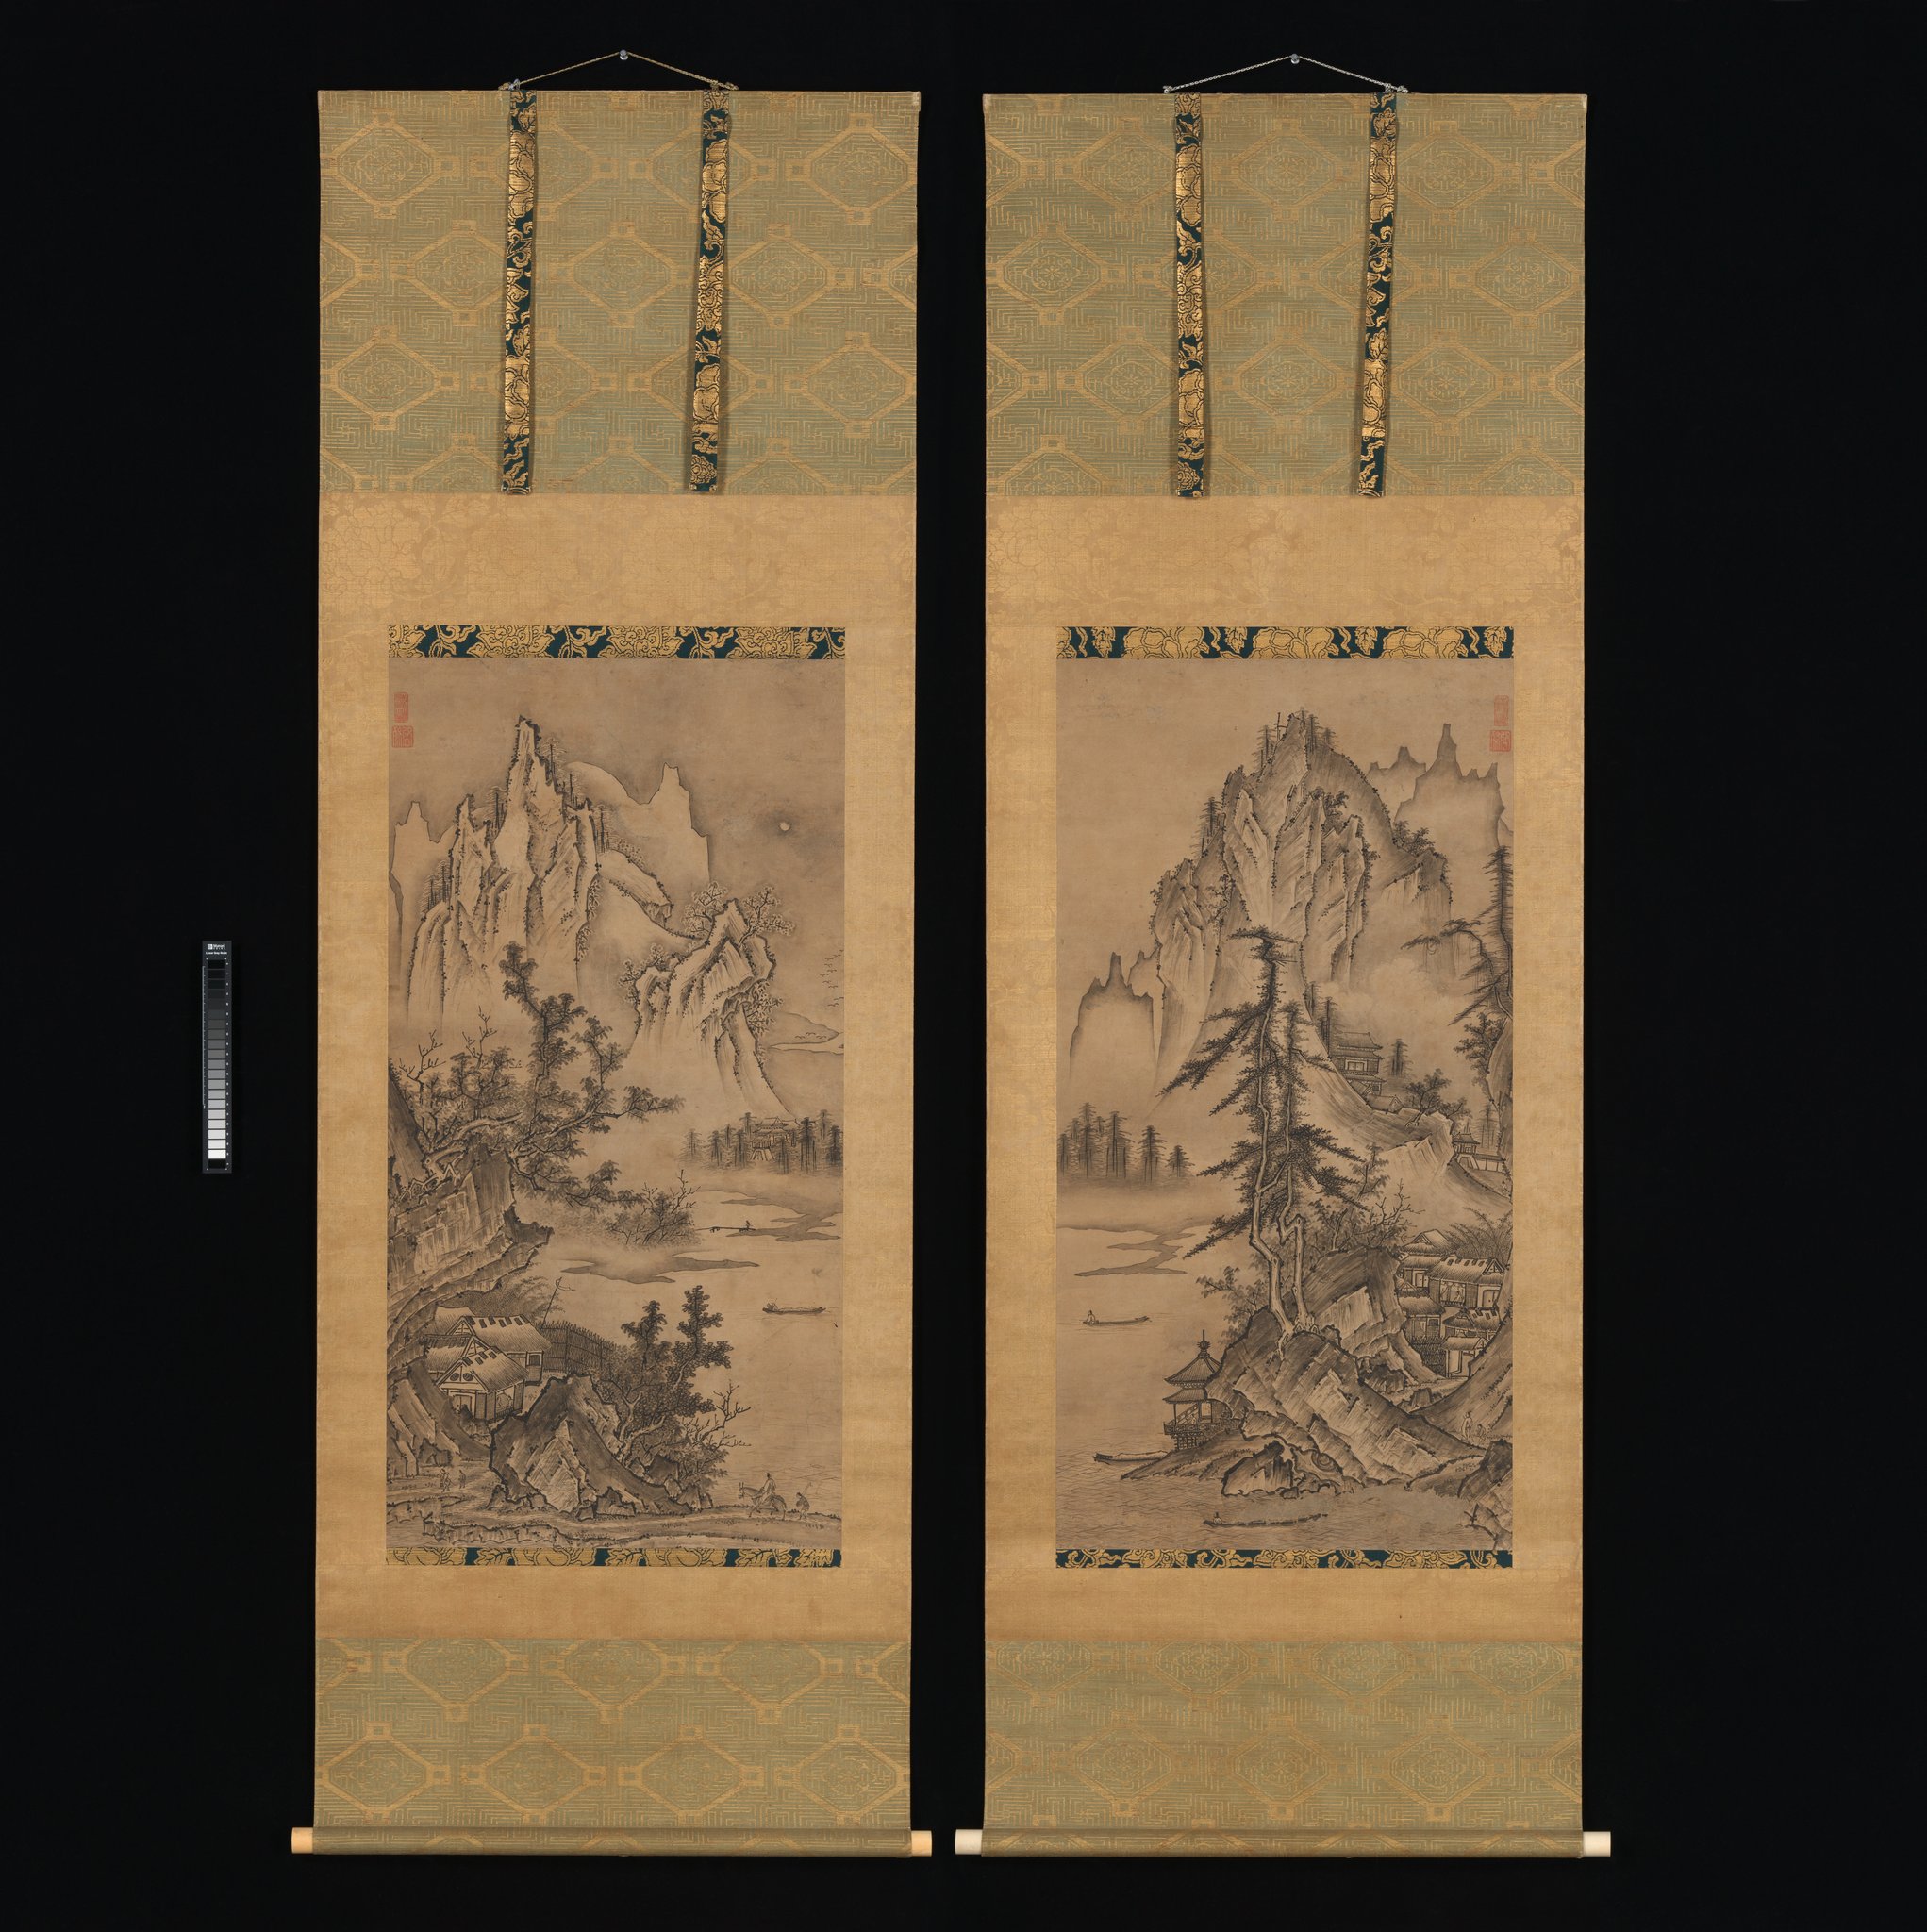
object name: hanging scroll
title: Landscapes of the Four Seasons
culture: japanese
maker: keison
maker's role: artist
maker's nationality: japanese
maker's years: 1534-1566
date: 1534-1566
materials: ink, paper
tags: mountains,landscapes